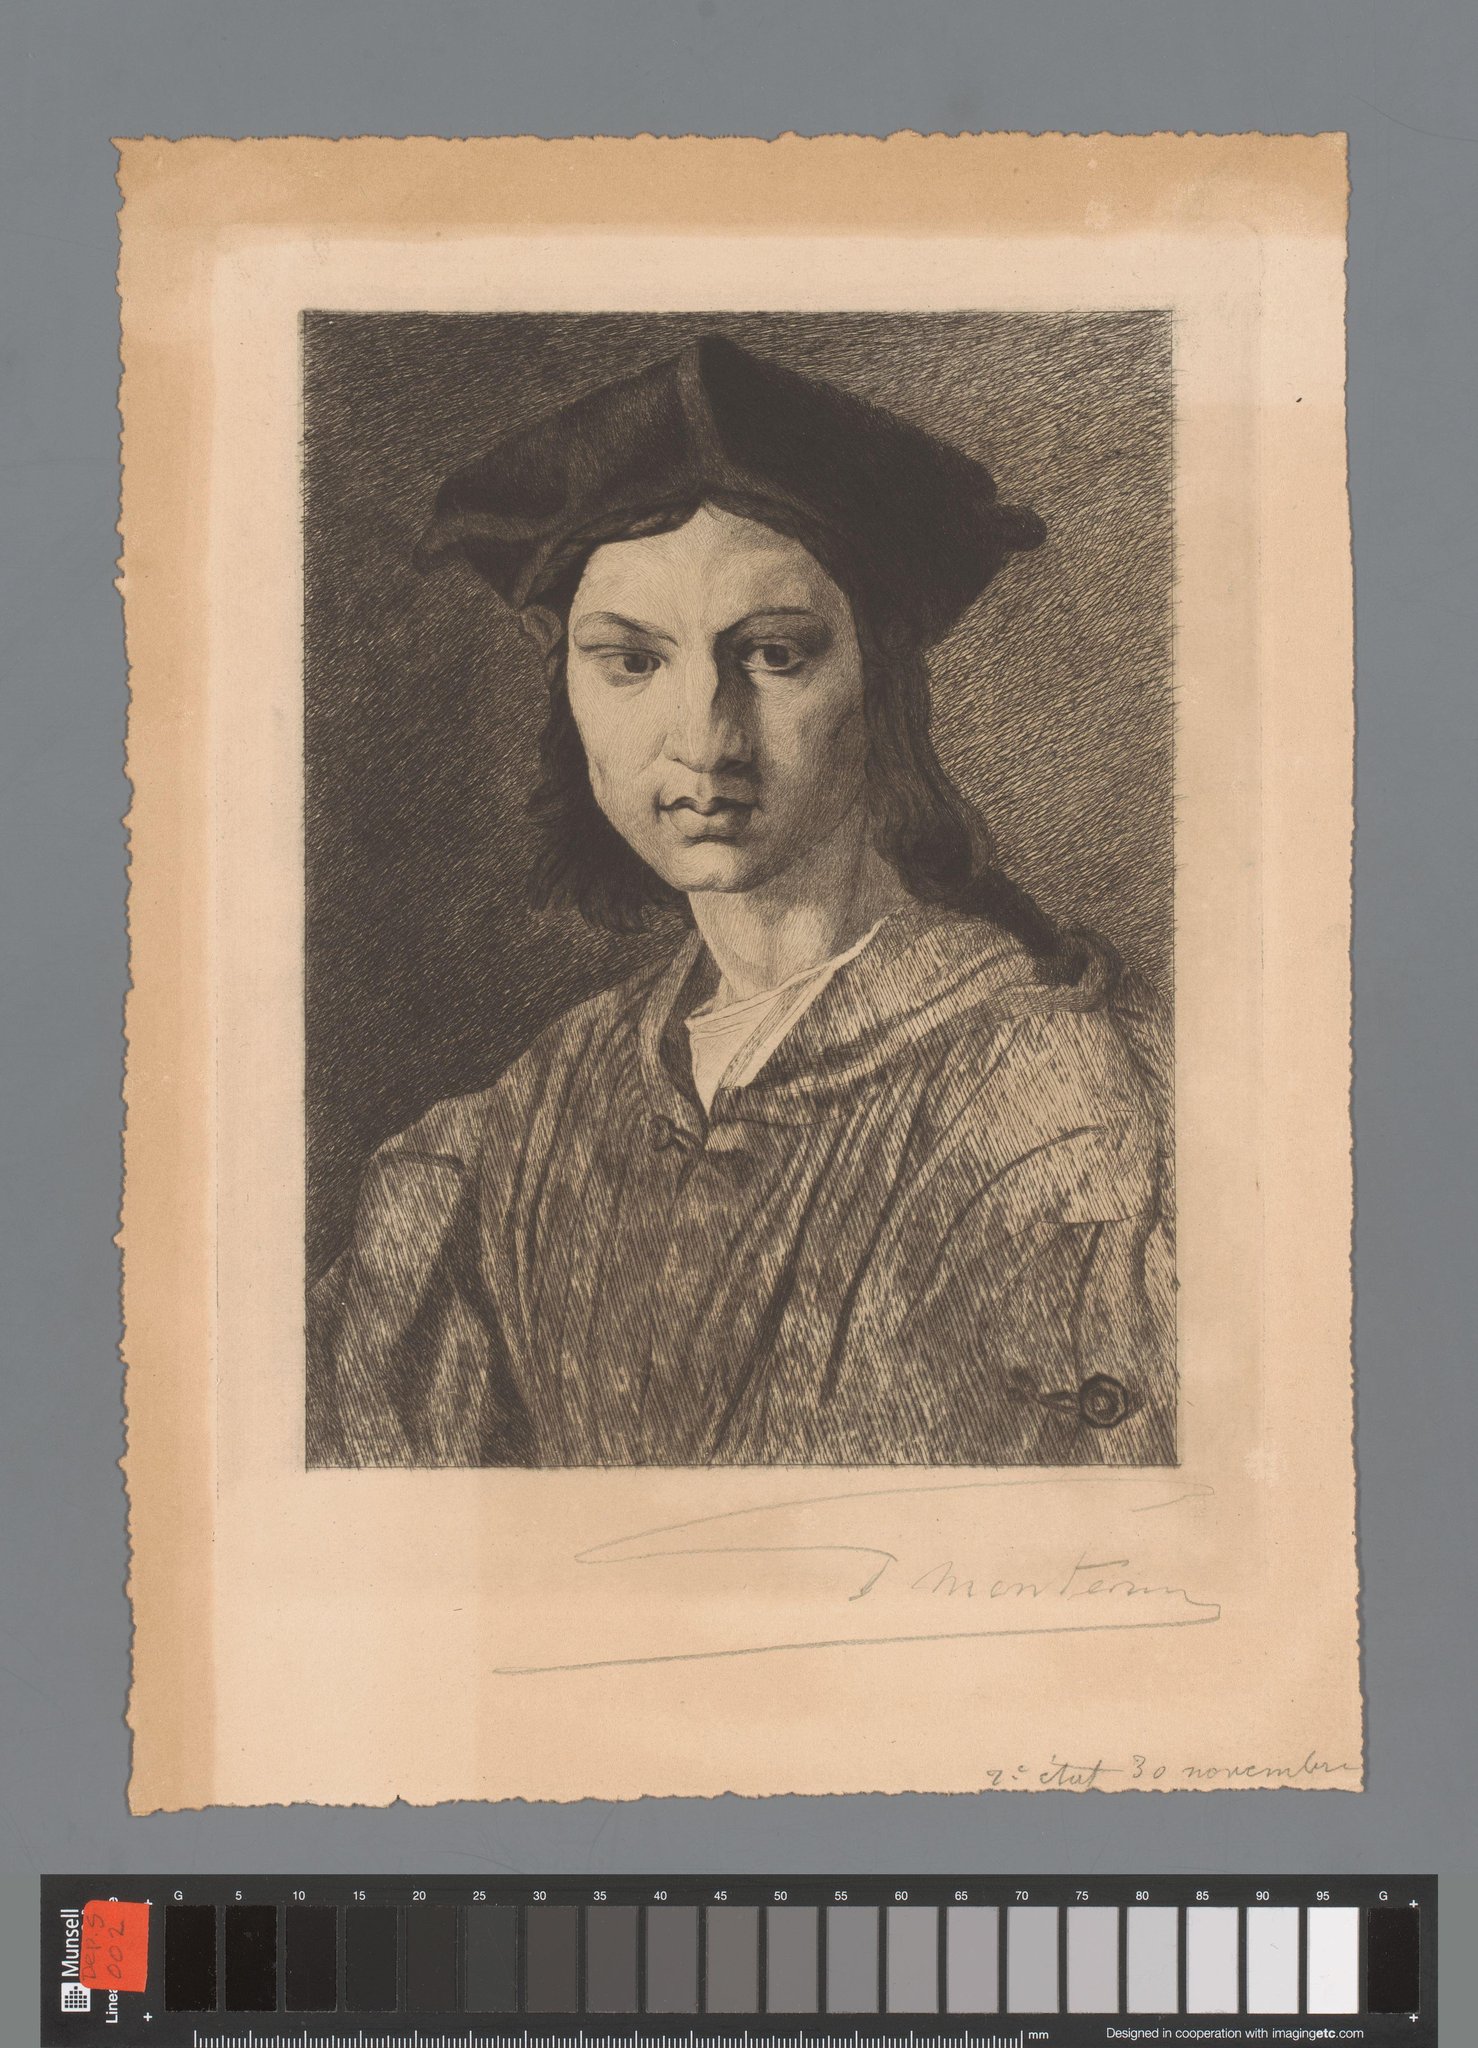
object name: print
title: Portret van Baccio Bandinelli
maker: georges montenez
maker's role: print maker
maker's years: 1873-1930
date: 1891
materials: paper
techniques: drypoint, etching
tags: draughtsman, baccio bandinelli, head-gear, adult man, historical persons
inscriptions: inscription: ‘2e état 30 novembre’, collector's mark: Lugt 2228